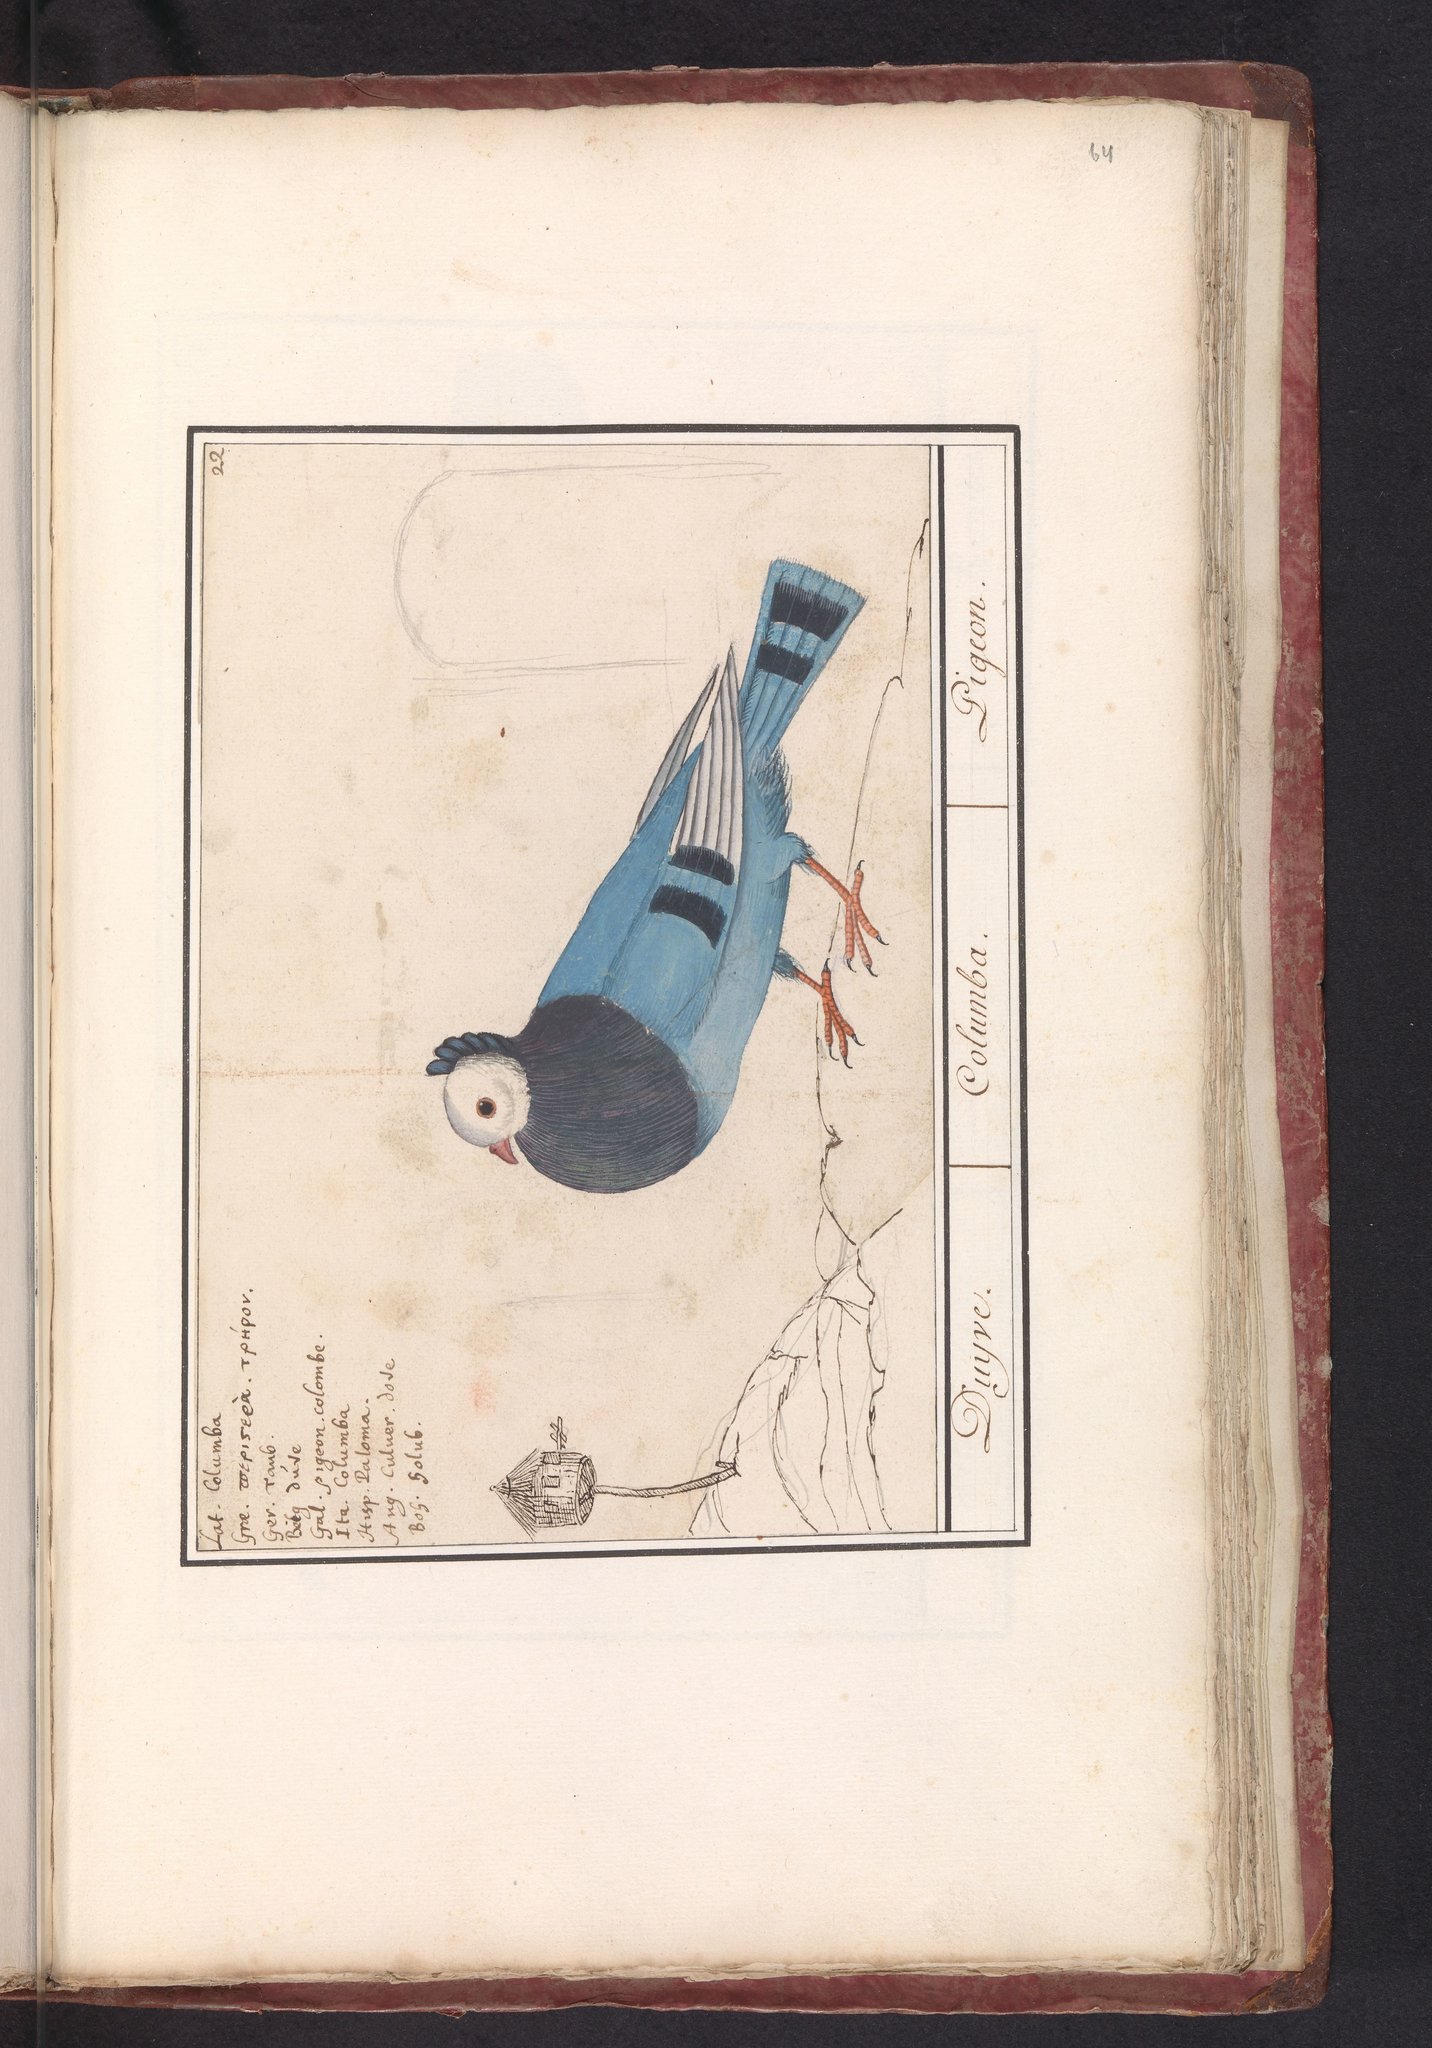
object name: drawing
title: Duif (Columbidae)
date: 1596-1610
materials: paint, ink, paper, pencil, watercolor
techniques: brush, pen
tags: other birds: dove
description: Duif, links een duiventil. Genummerd rechtsboven: 22. Linksboven de naam in negen talen. Onderdeel van het eerste album met tekeningen van vogels. Derde van twaalf albums met tekeningen van dieren, vogels en planten bekend rond 1600, gemaakt in opdracht van keizer Rudolf II. Met toelichting in Nederlands, Latijn en Frans.